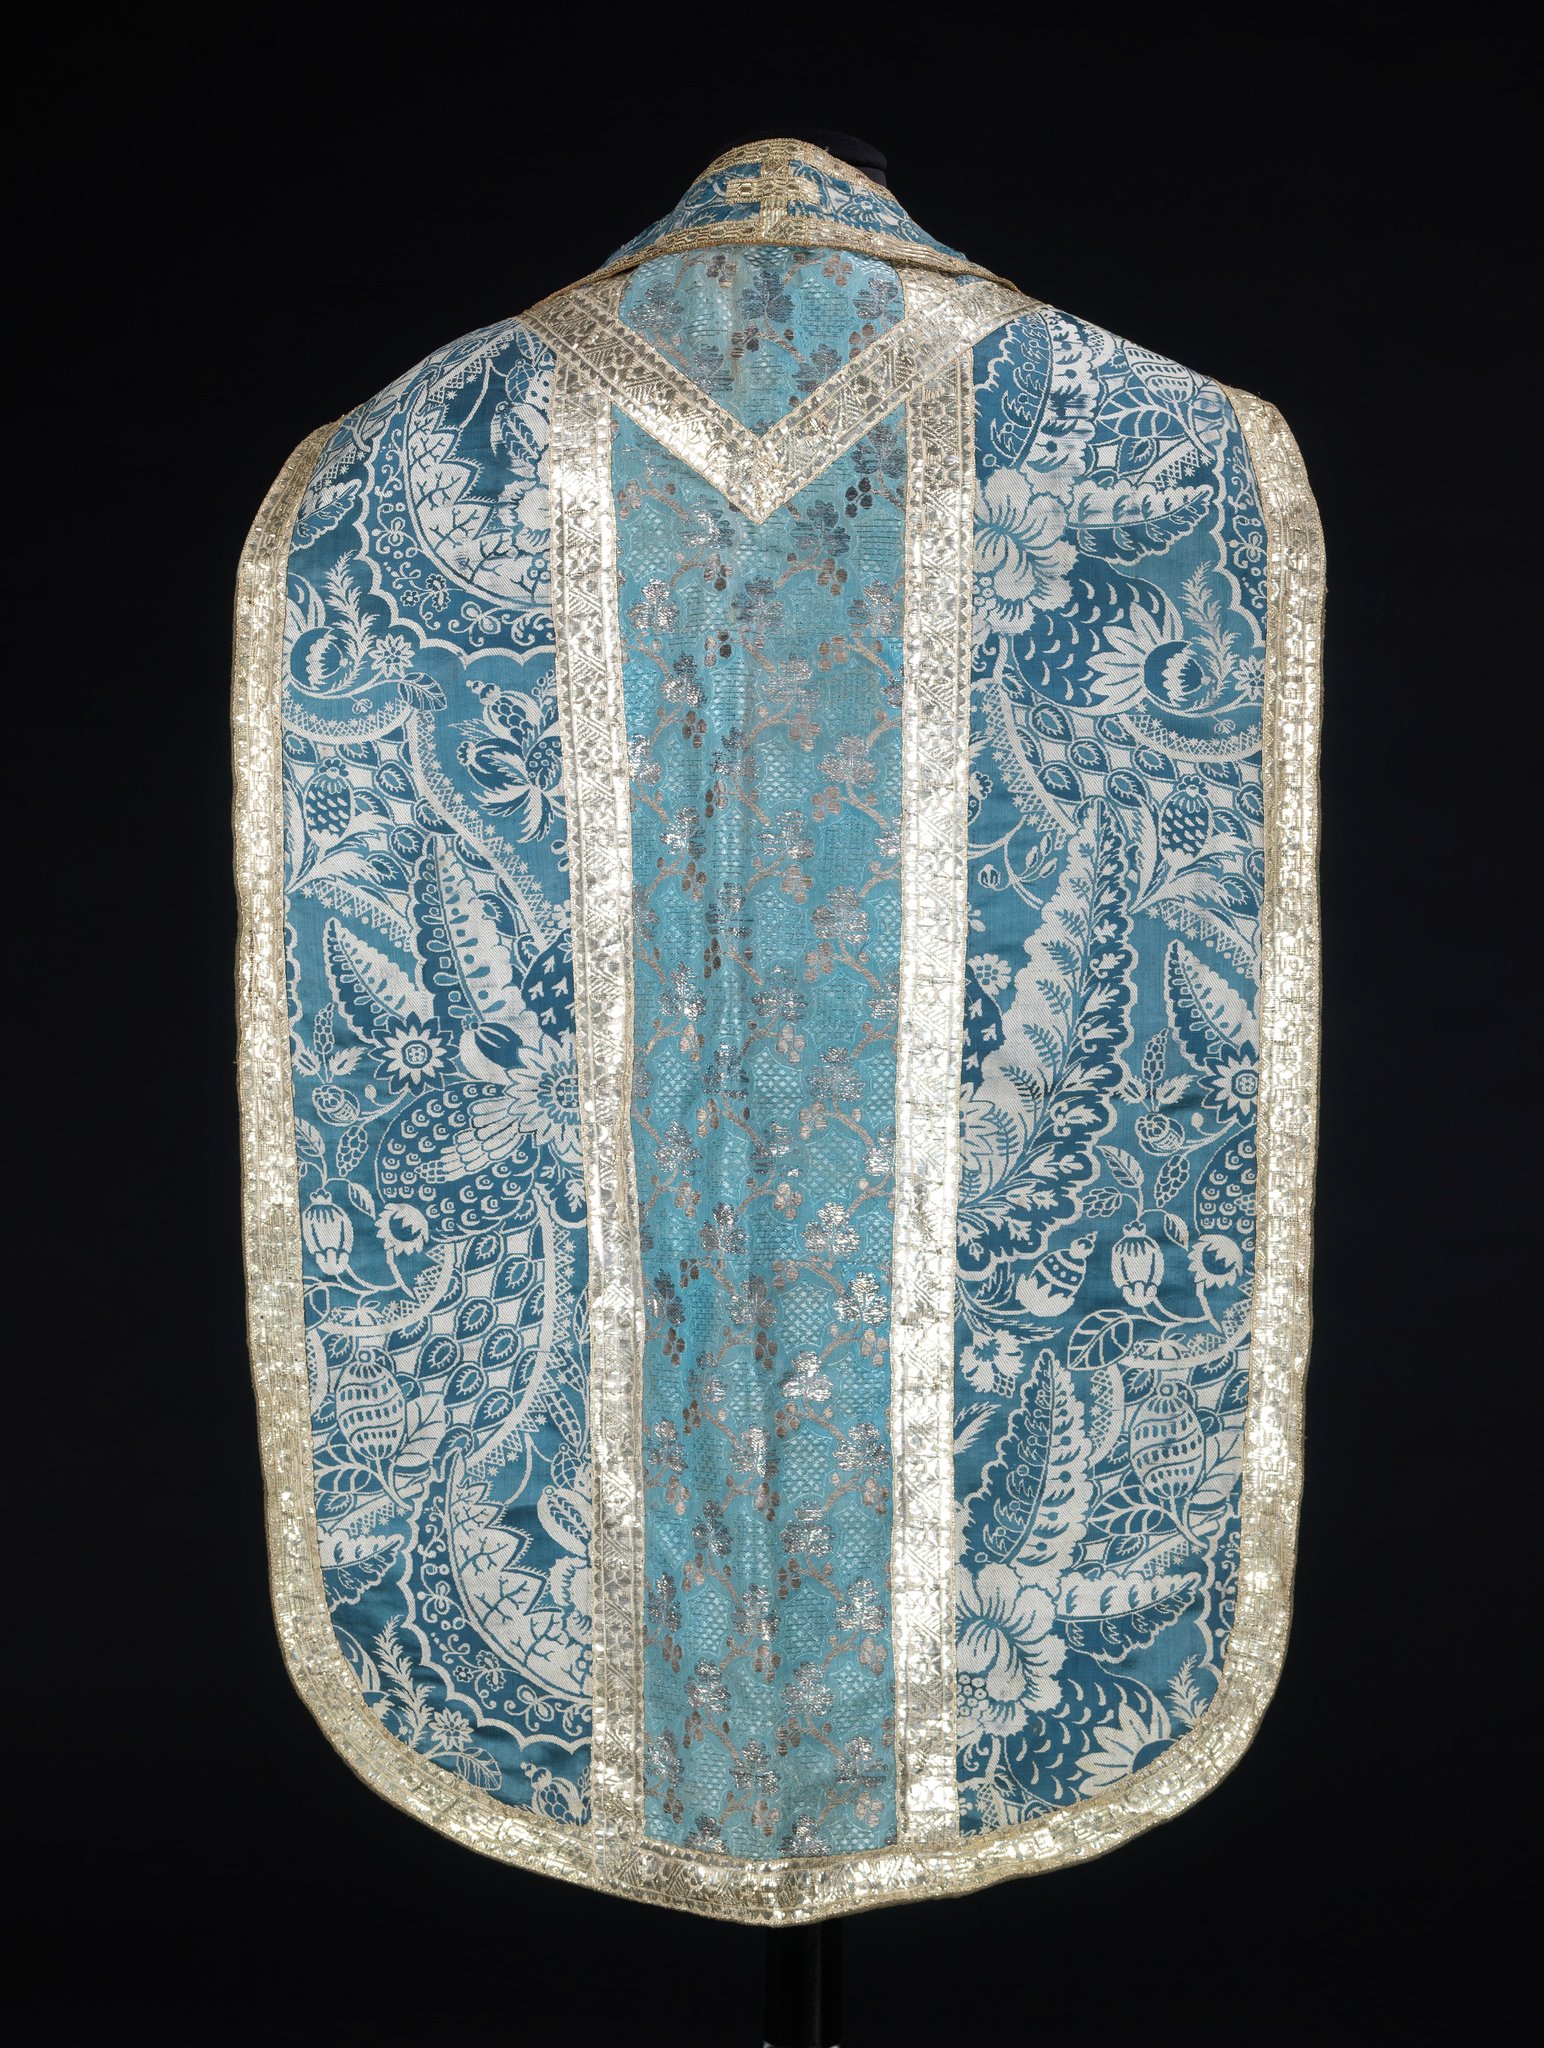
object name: vestment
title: Chasuble, stole and maniple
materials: metal, silk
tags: flowers,leaves